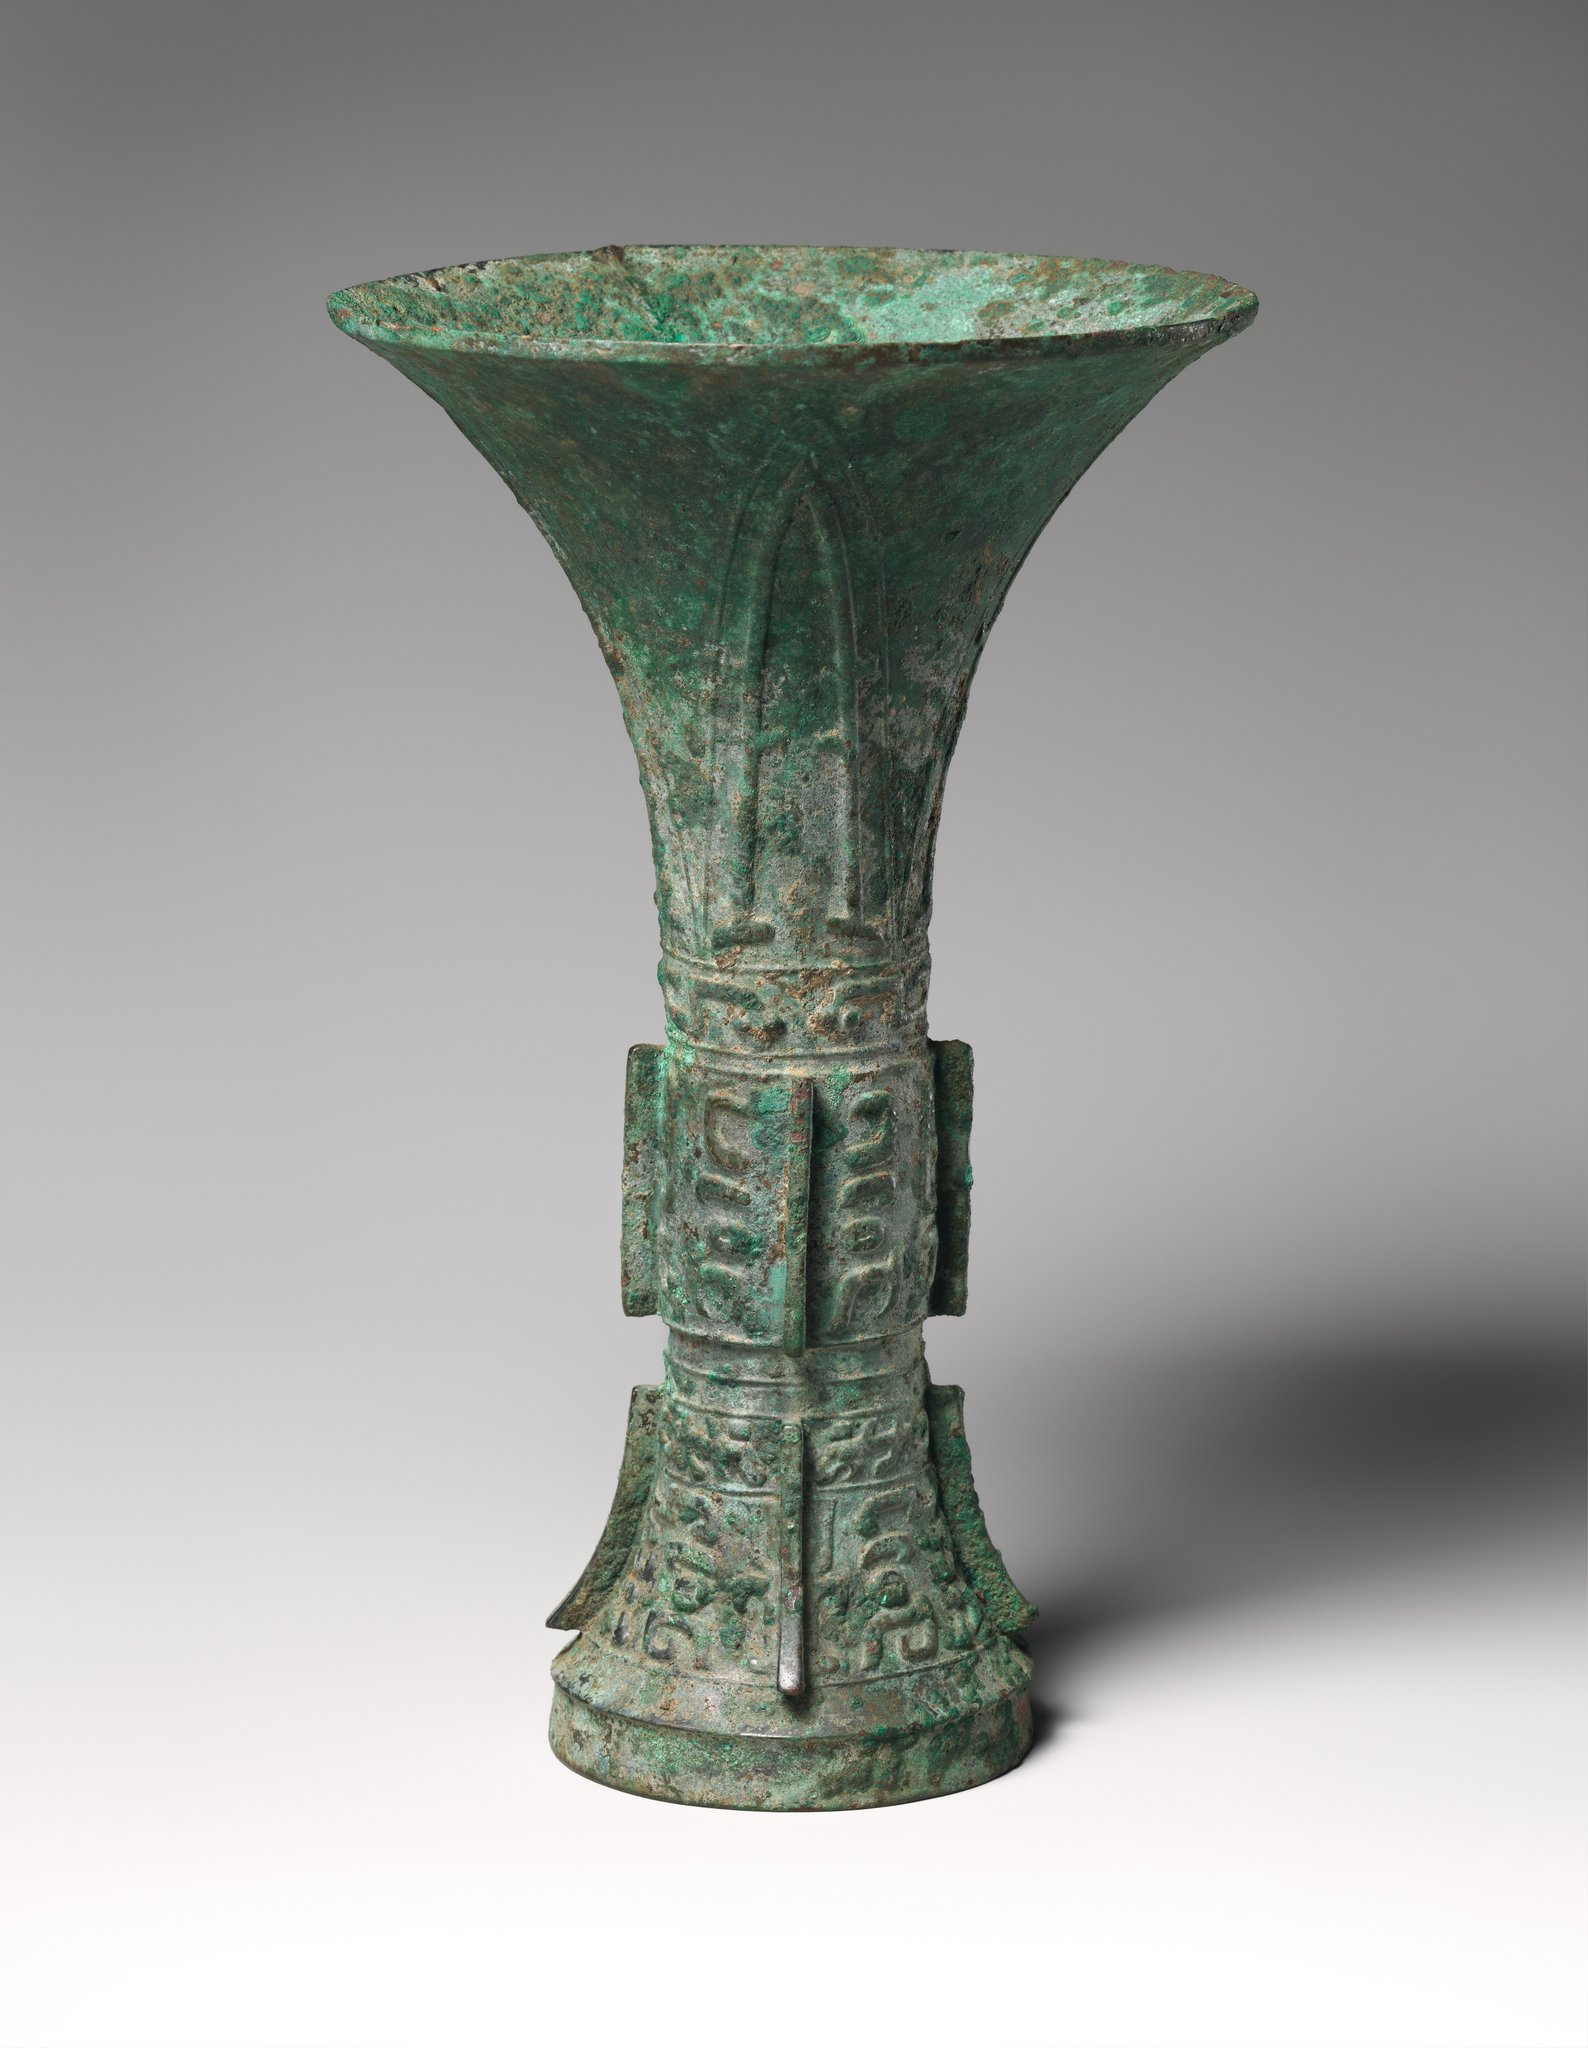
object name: wine beaker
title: Ritual Wine Beaker (Gu)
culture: chinese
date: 1034-1001 BCE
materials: bronze